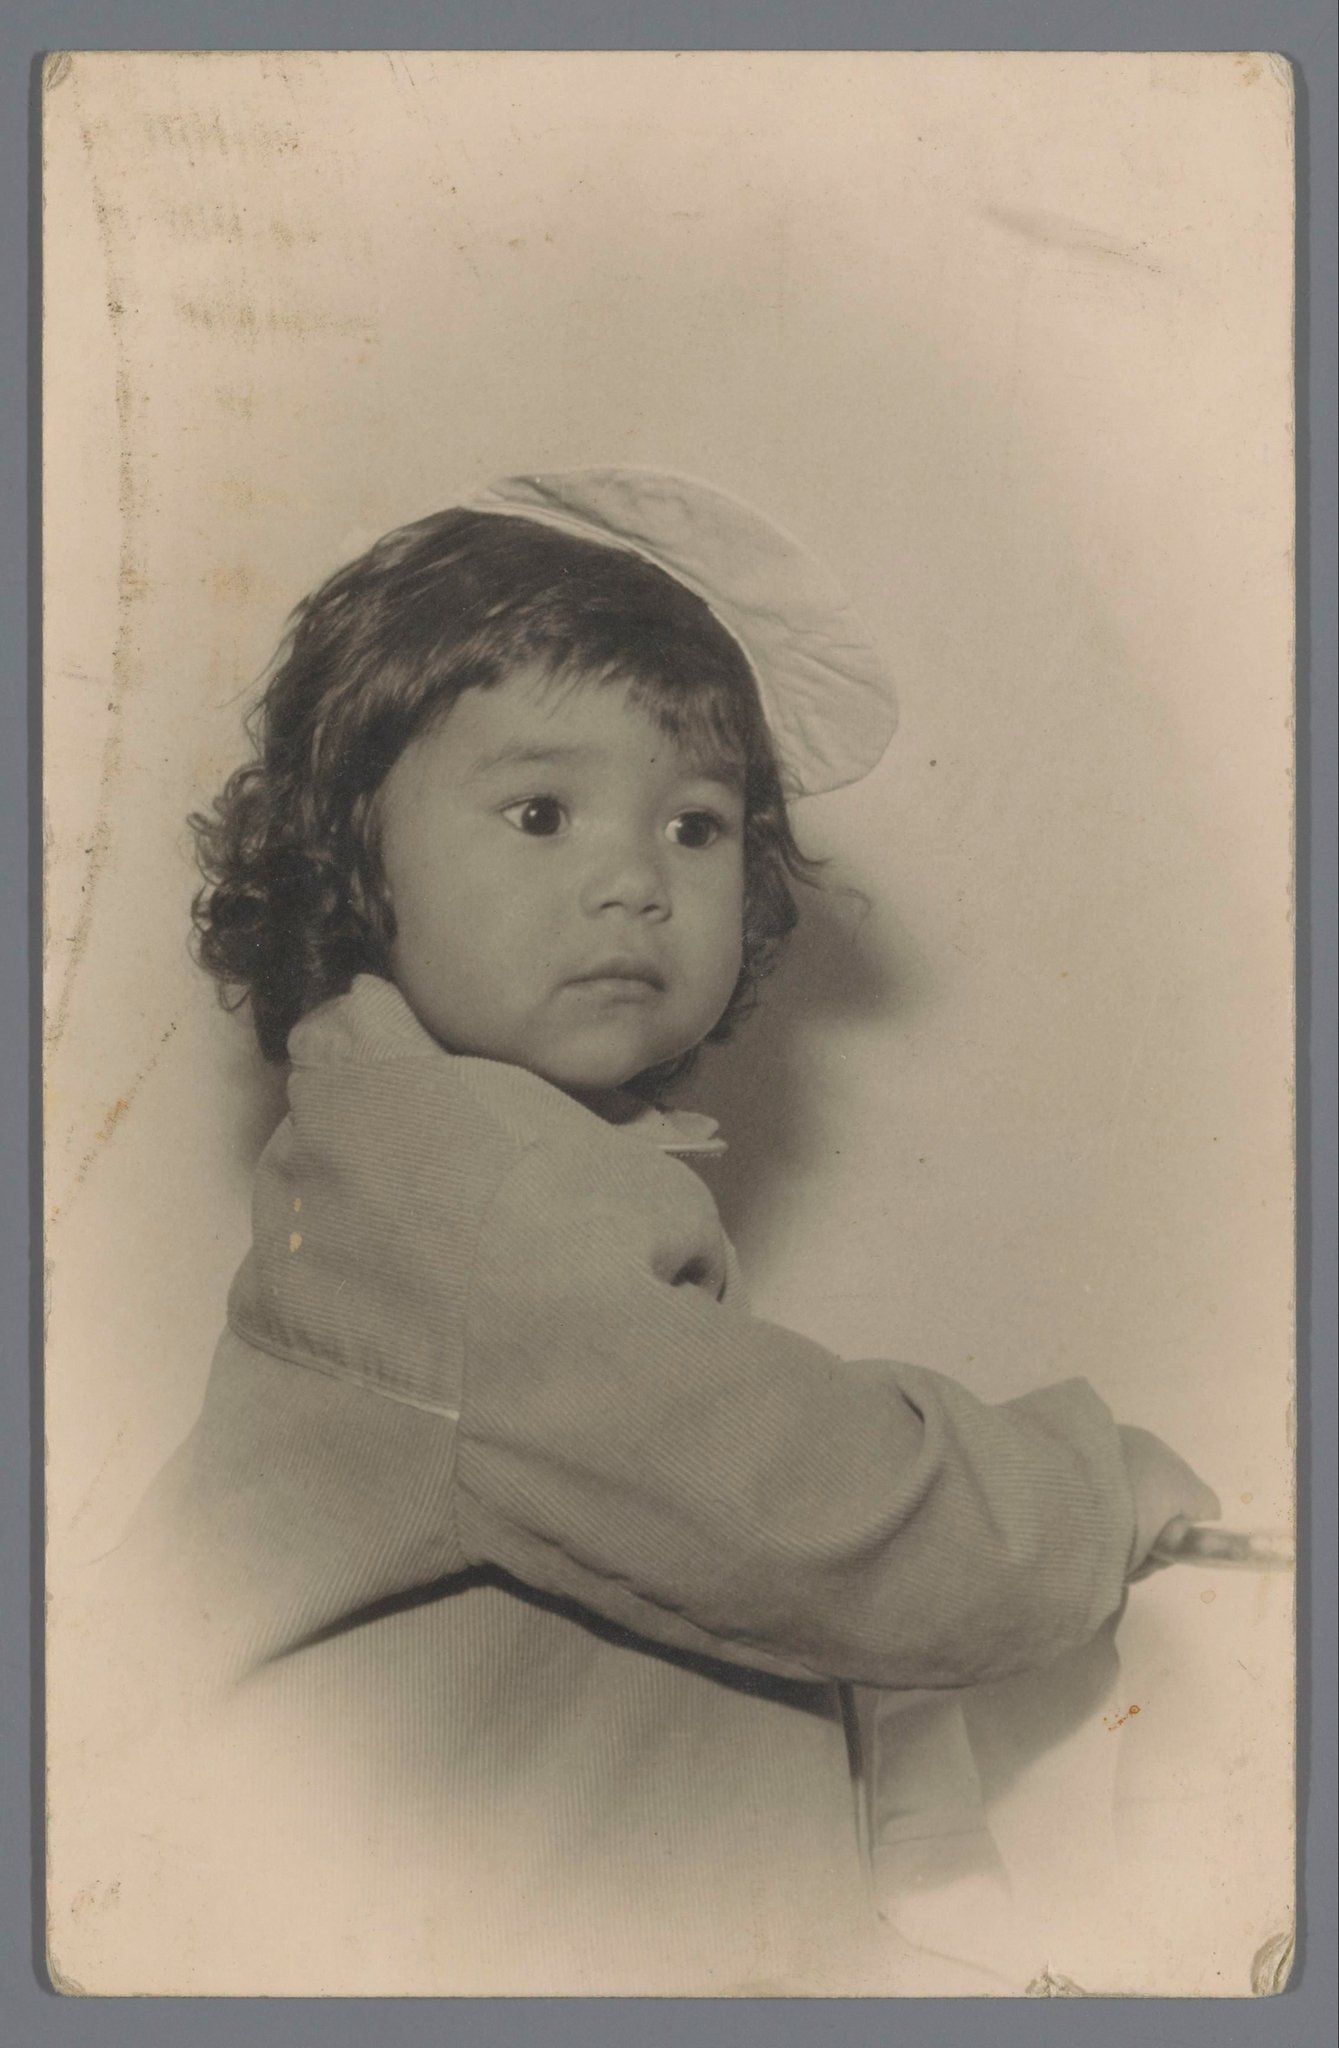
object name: ansichtkaart, prentbriefkaart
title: Portret van een onbekend kind met een baret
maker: paul rollman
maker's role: fotograaf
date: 1935-1950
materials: photographic support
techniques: gelatin silver print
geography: amsterdam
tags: head-gear: beret, infant, baby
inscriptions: inscription: ‘Paul Rollman spec. fotograaf v. Lennepstraat 318 Amsterdam-West’